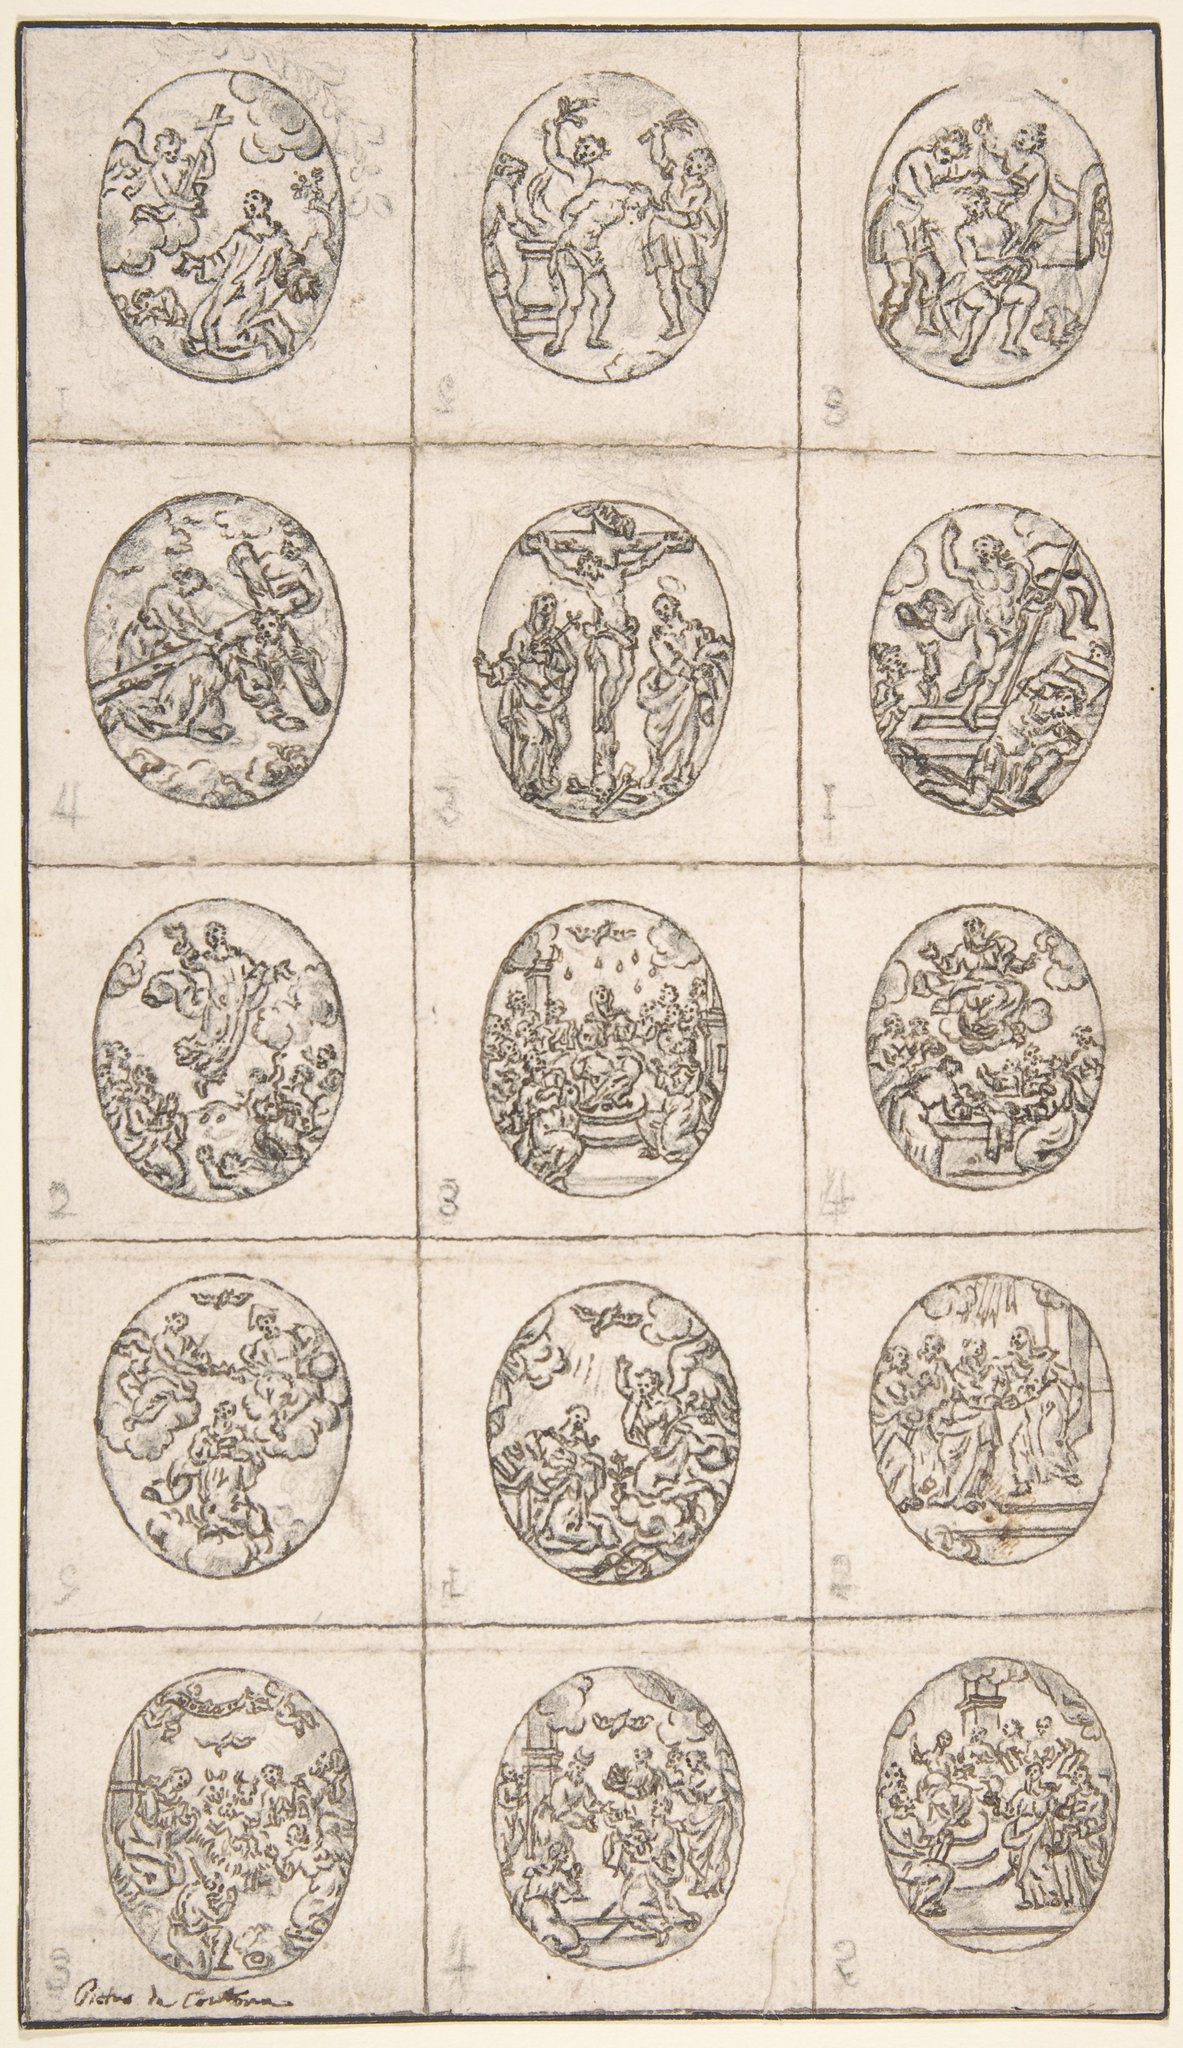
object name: drawing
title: 15 Oval Scenes From the Life of Christ and a Scene of a Saint Adoring the Holy Cross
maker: anonymous, italian, 17th or 18th century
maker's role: artist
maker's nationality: italian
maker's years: 1600-1799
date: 1670-1740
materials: chalk, ink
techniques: pen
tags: christ